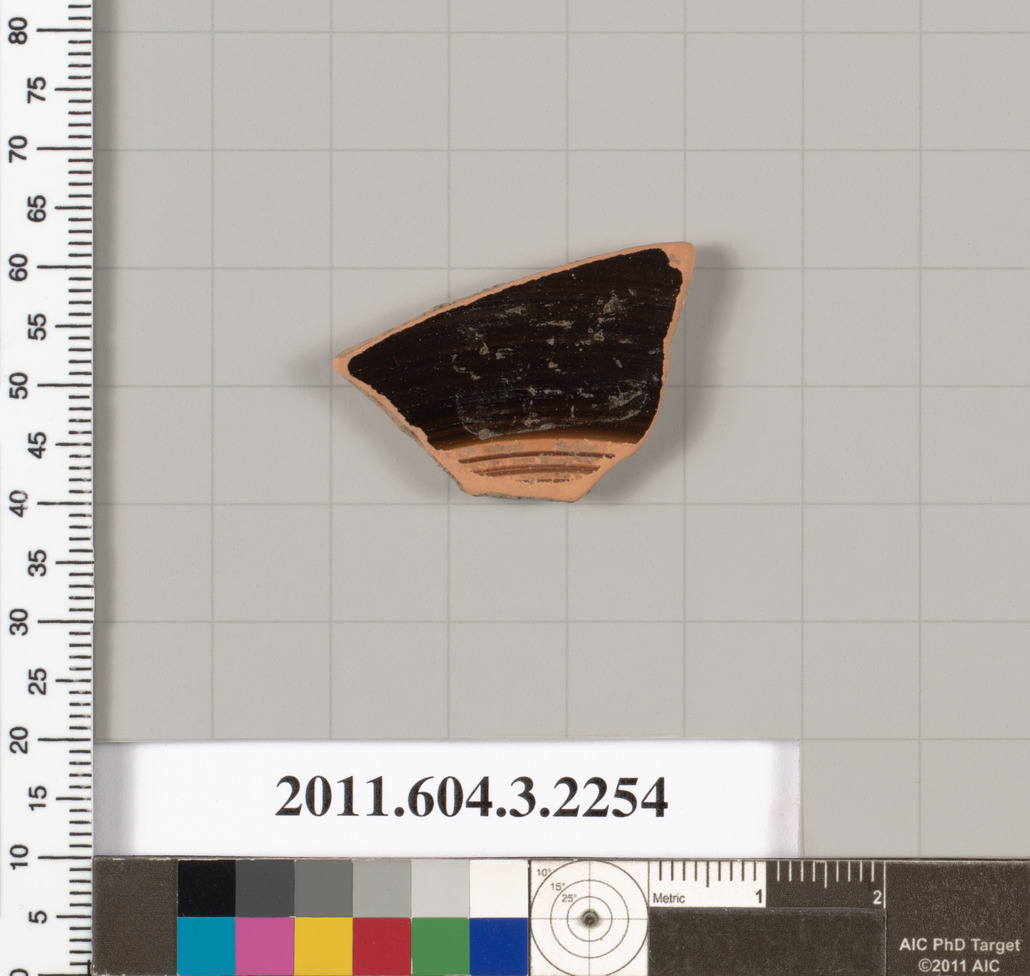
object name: kylix fragment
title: Terracotta fragment of a kylix (drinking cup)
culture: greek, attic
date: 600-401 BCE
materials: terracotta